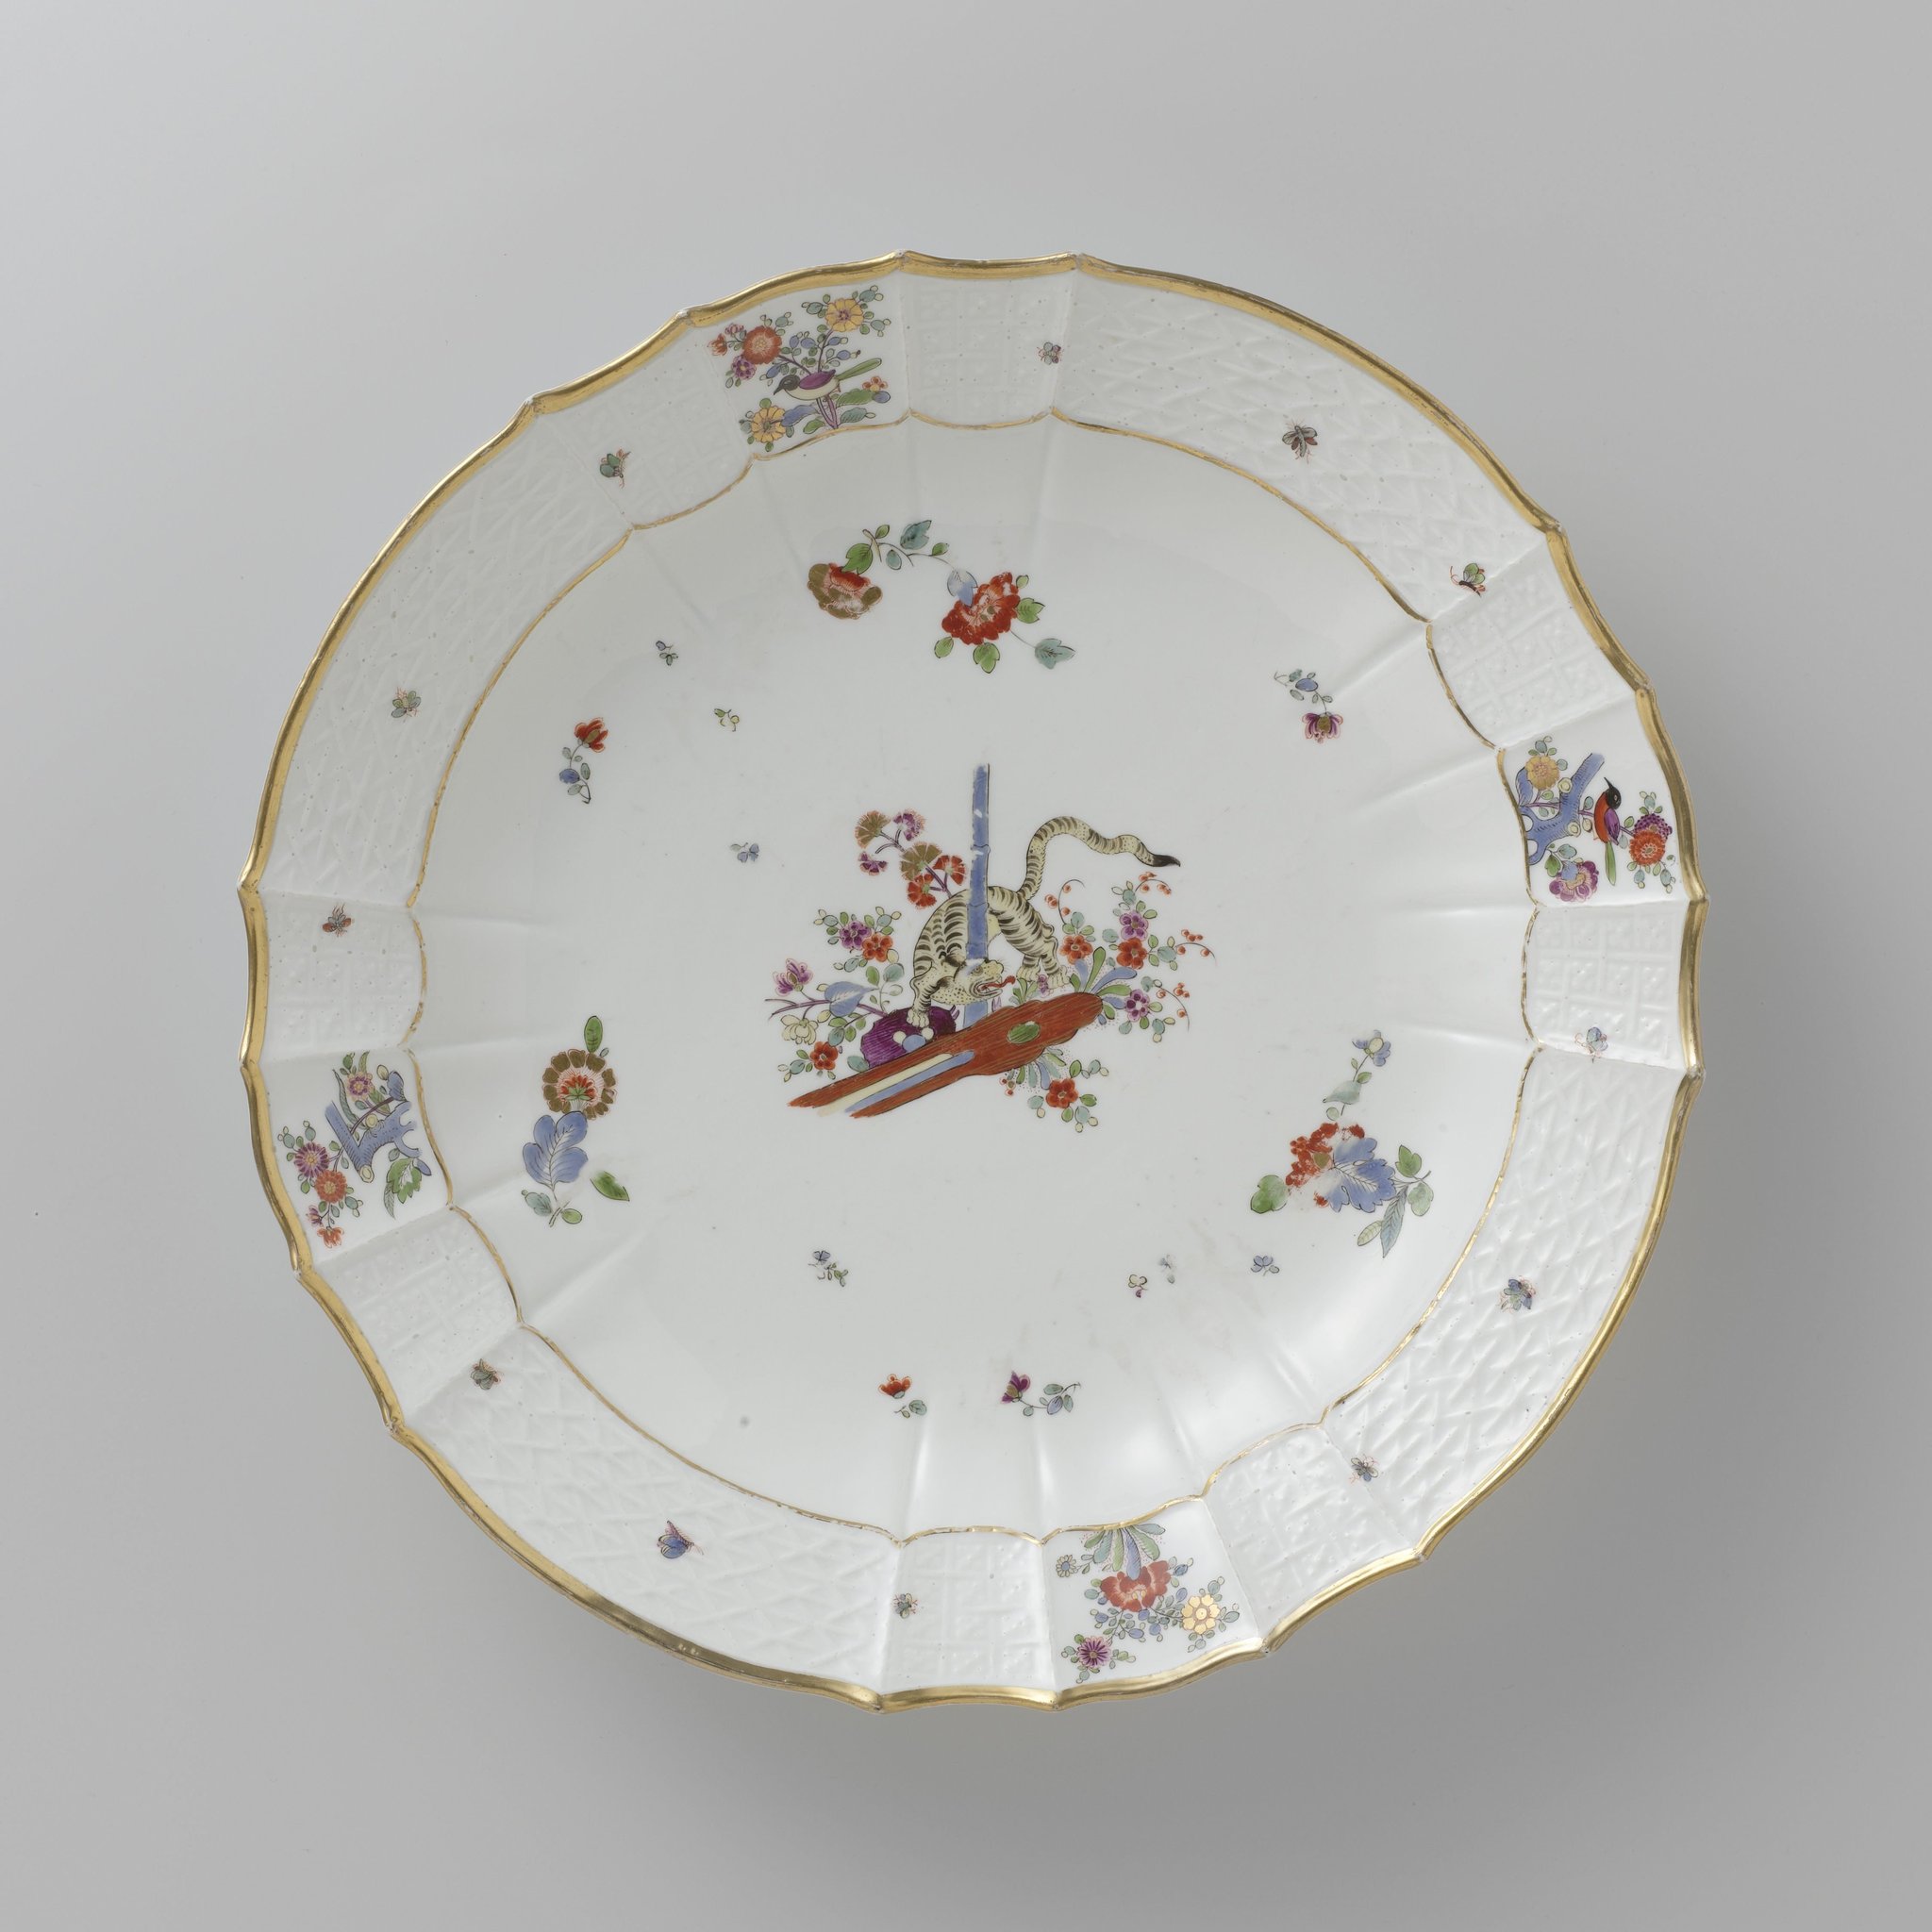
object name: platter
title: Schotel, veelkleurig beschilderd met een Kakiemon-decor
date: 1740-1745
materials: porcelain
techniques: painted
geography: meissen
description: Ronde schotel van beschilderd porselein. De schotel heeft een geribde en geschulpte rand. De schotel is beschilderd met een tijger om een bamboestengel, gestrooide Indianische Blumen, vlinders en takken met vogels. De rand is versierd met het 'Altbrandenstein'-patroon. De schotel is gemerkt.